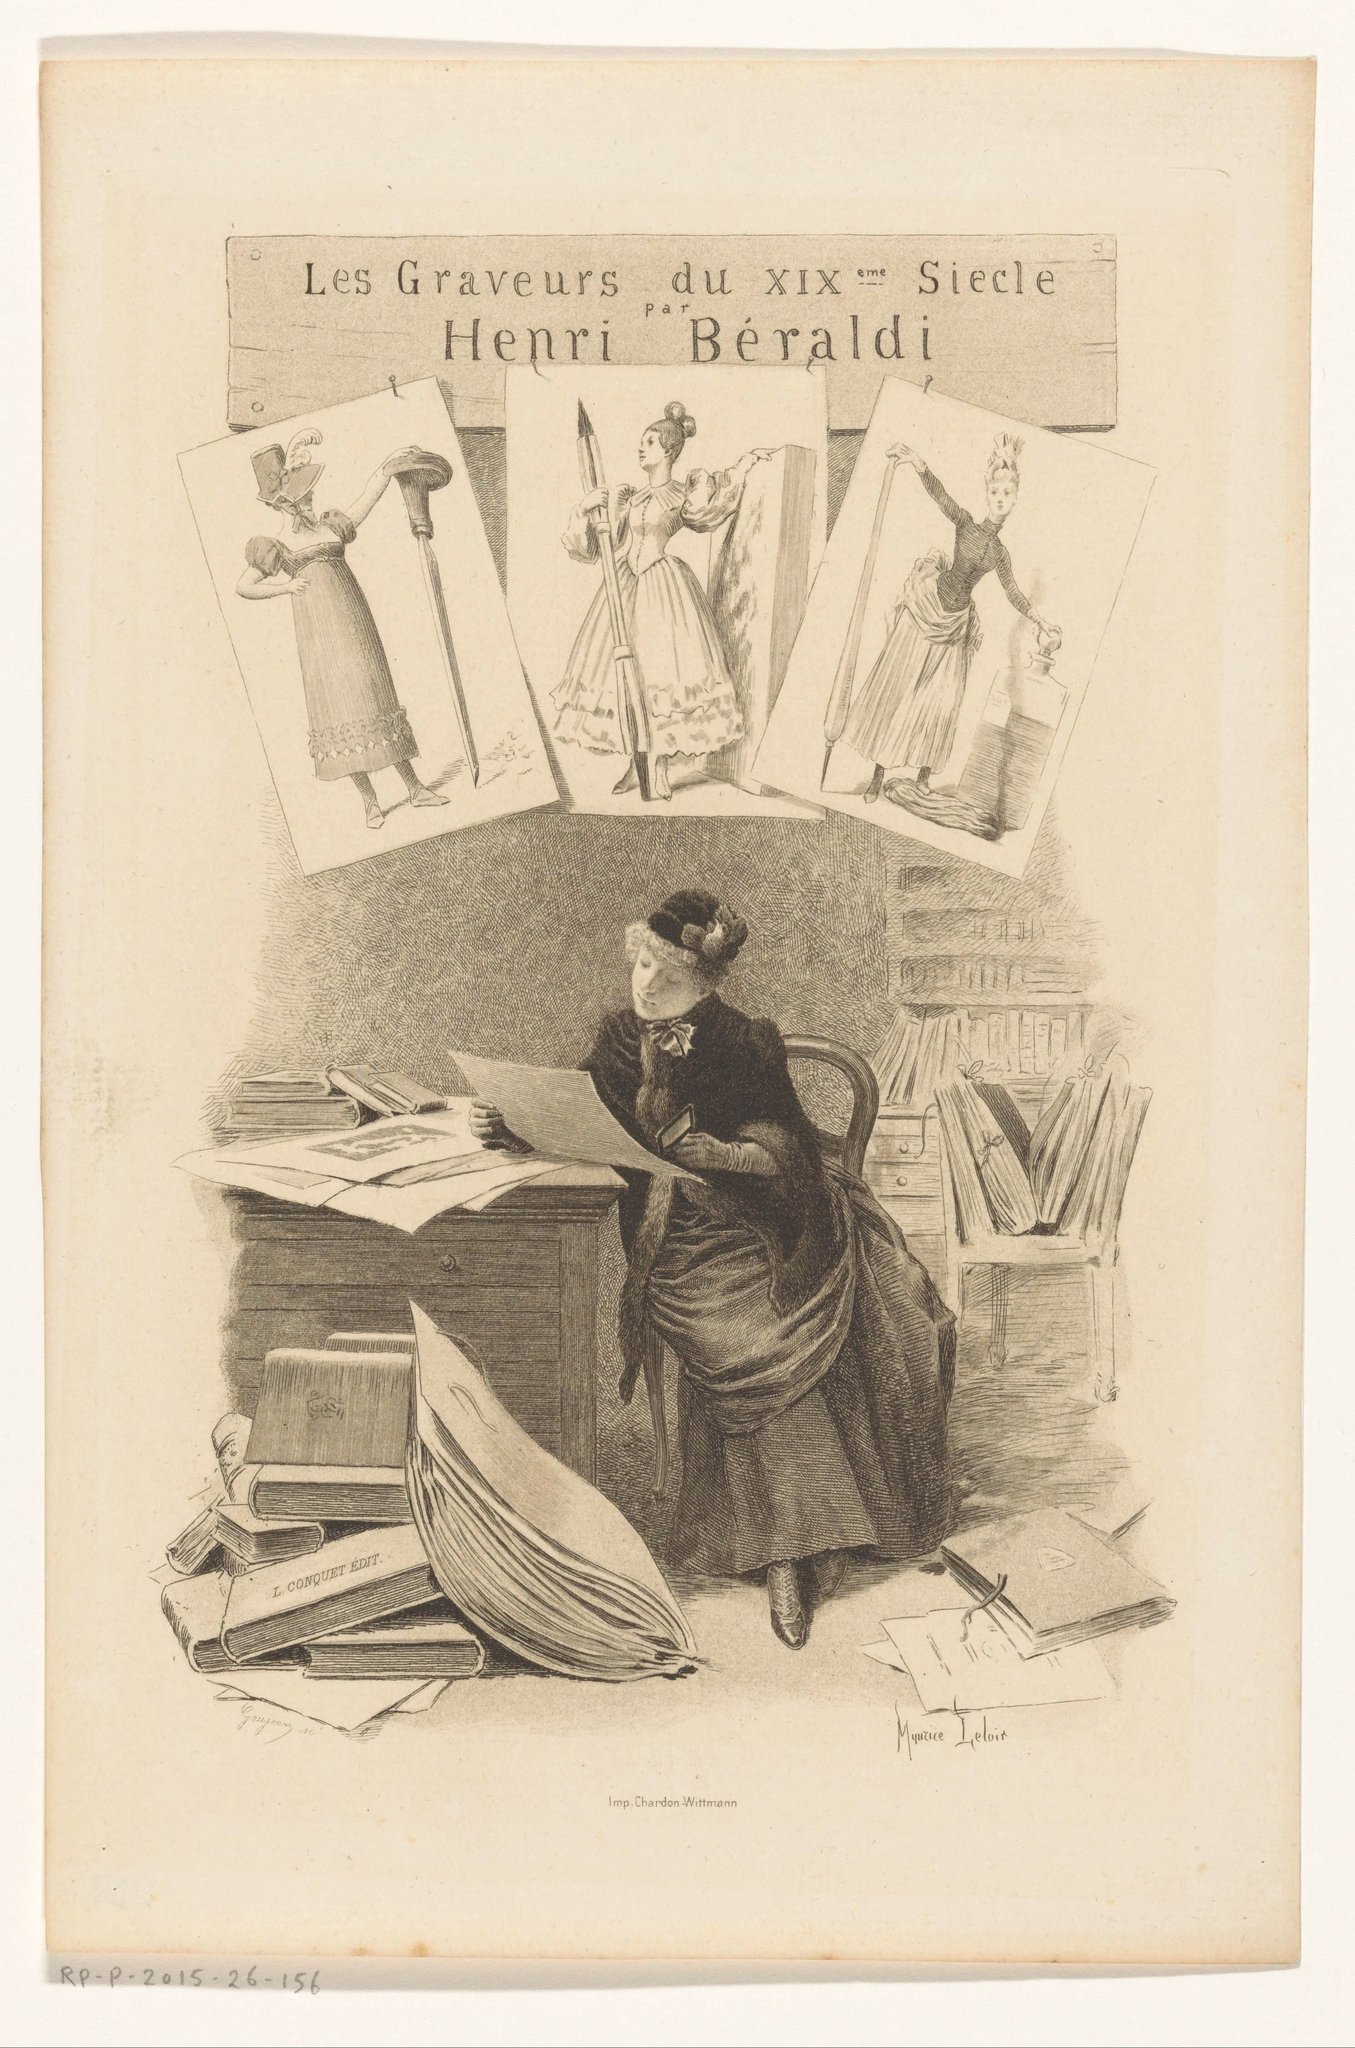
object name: print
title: Vrouw bekijkt prenten achter een bureau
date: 1899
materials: paper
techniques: etching, roulette, soft ground etching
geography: paris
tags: art collection, art gallery, tools, implements of graphic artist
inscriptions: collector's mark: Lugt 2228, collector's mark: Lugt 4780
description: Een vrouw bekijkt prenten achter een bureau, een prent in haar ene hand, een vergrootglas in de ander. Verspreid over het bureau en op de grond liggen losse prenten, albums en portfolio's. Boven de vrouw zijn drie prenten afgebeeld. Hierop zijn drie vrouwen te zien met de gereedschappen van een prentmaker: een burijn, een houder met lithografisch krijt en een etsnaald.